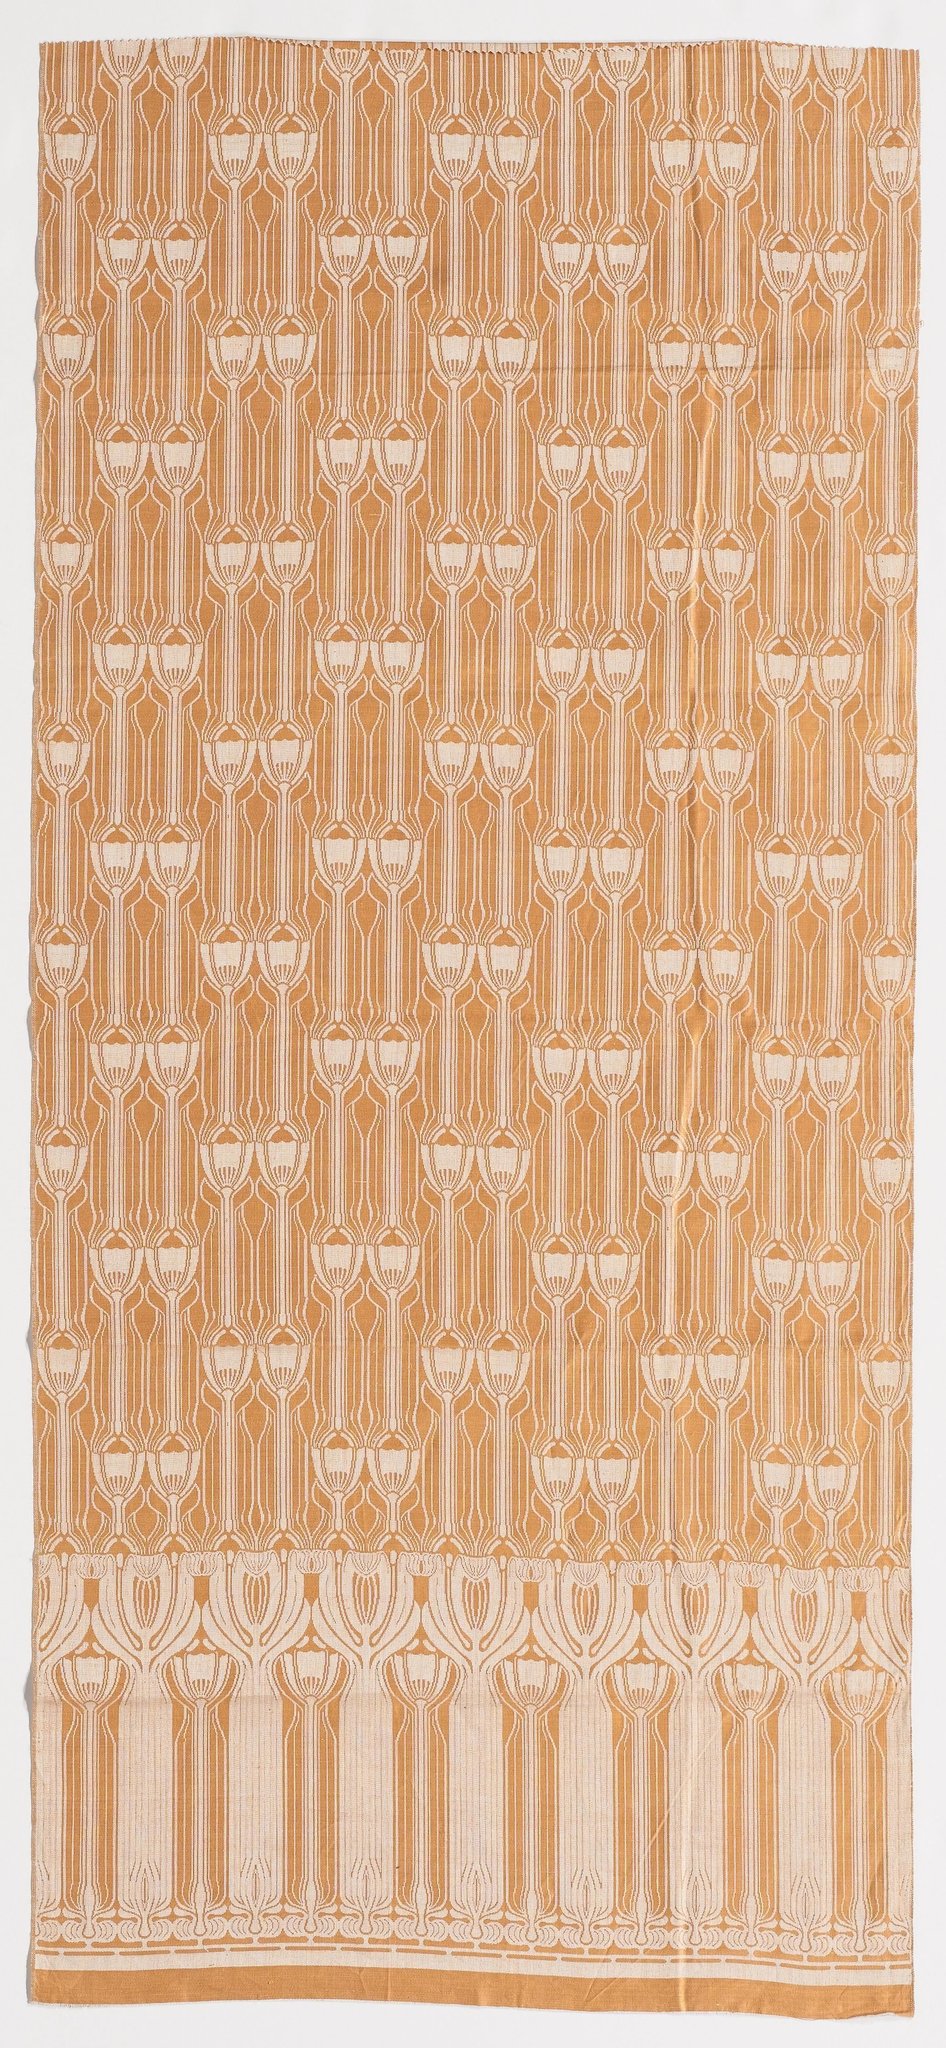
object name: upholstered wall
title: Wandbespanning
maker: chris lebeau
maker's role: draughtsman, print maker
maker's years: 1878-1945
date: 1911-1915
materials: linen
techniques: damask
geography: eindhoven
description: Oranje-bruine damasten wandbespanning met een dessin van tulpen.